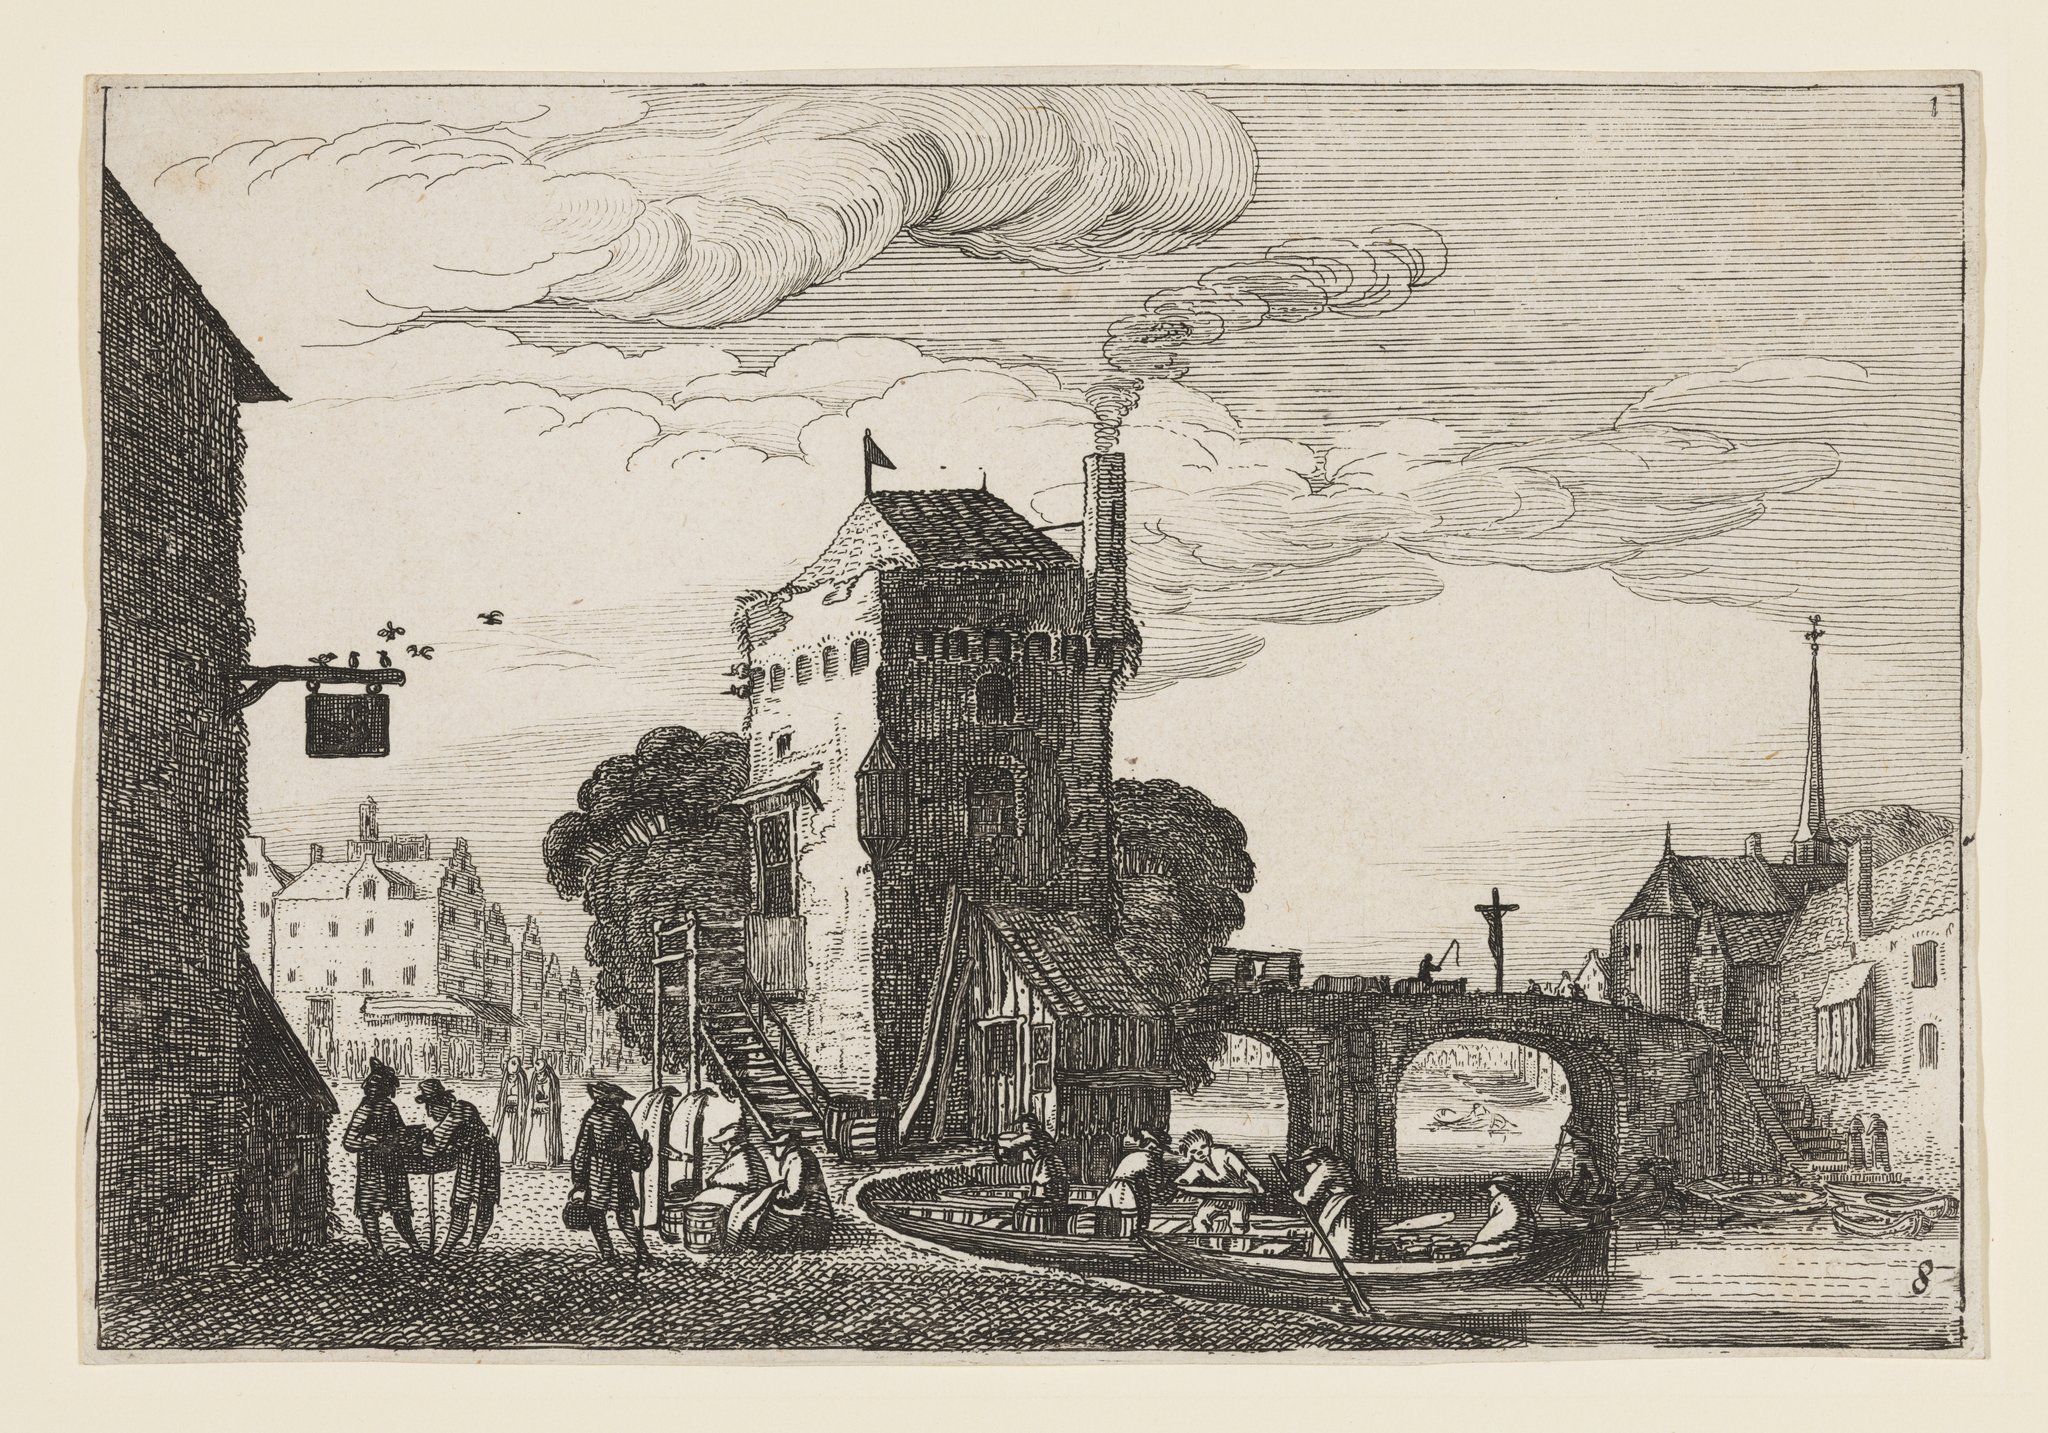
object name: print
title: View of a Town with a Canal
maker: jan van de velde (i)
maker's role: artist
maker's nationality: netherlandish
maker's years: 1568-1623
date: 1601-1633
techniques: etching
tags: canals,boats